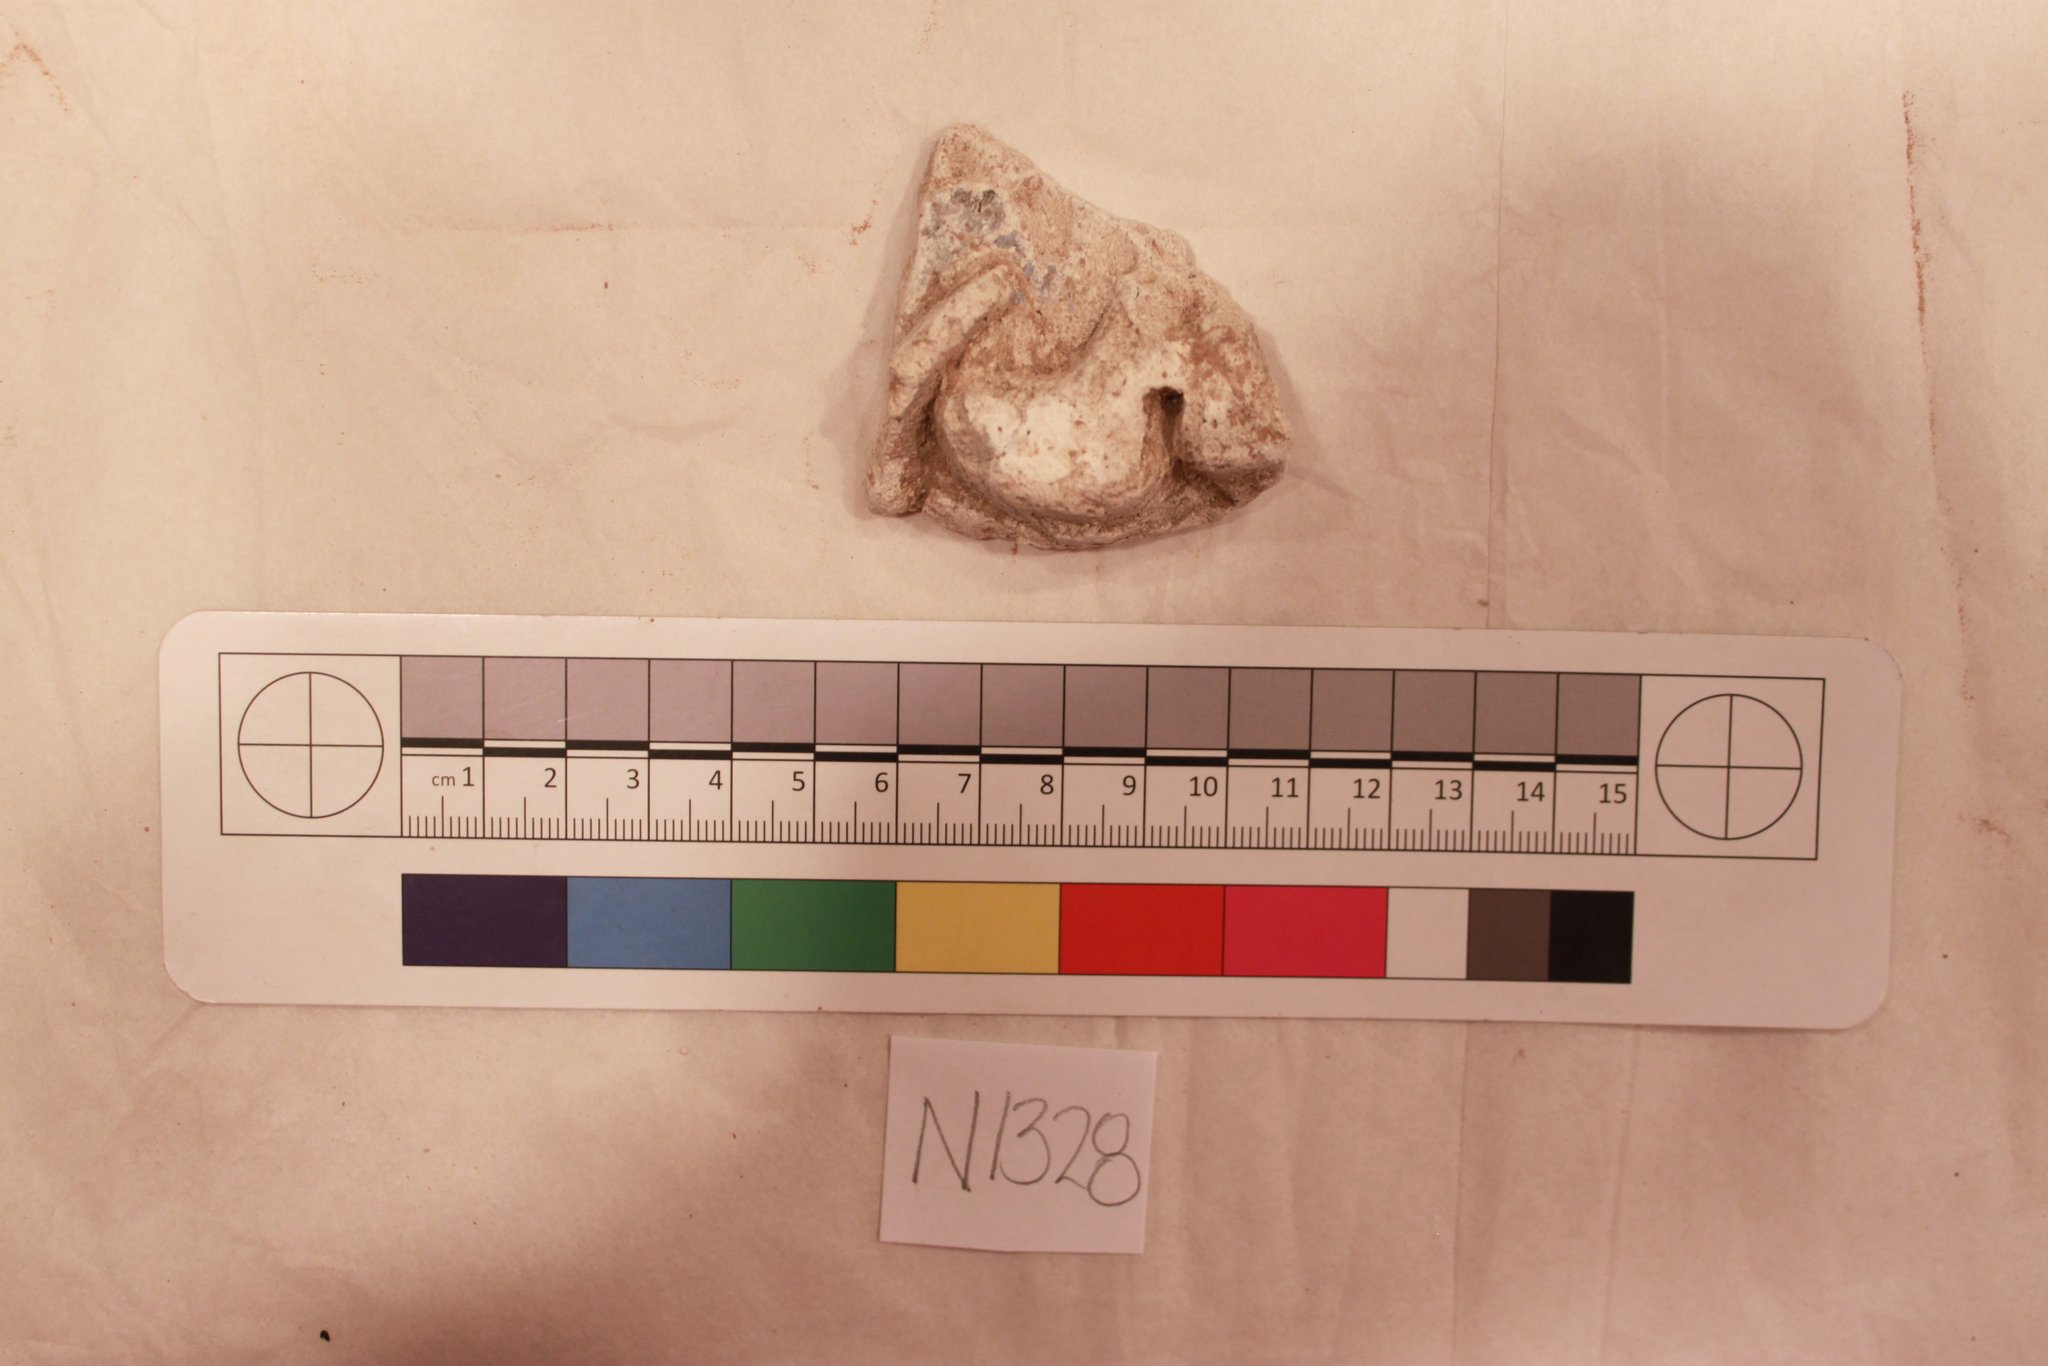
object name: fragment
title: Stucco Fragment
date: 701-1200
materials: plaster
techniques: carving, painting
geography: iran